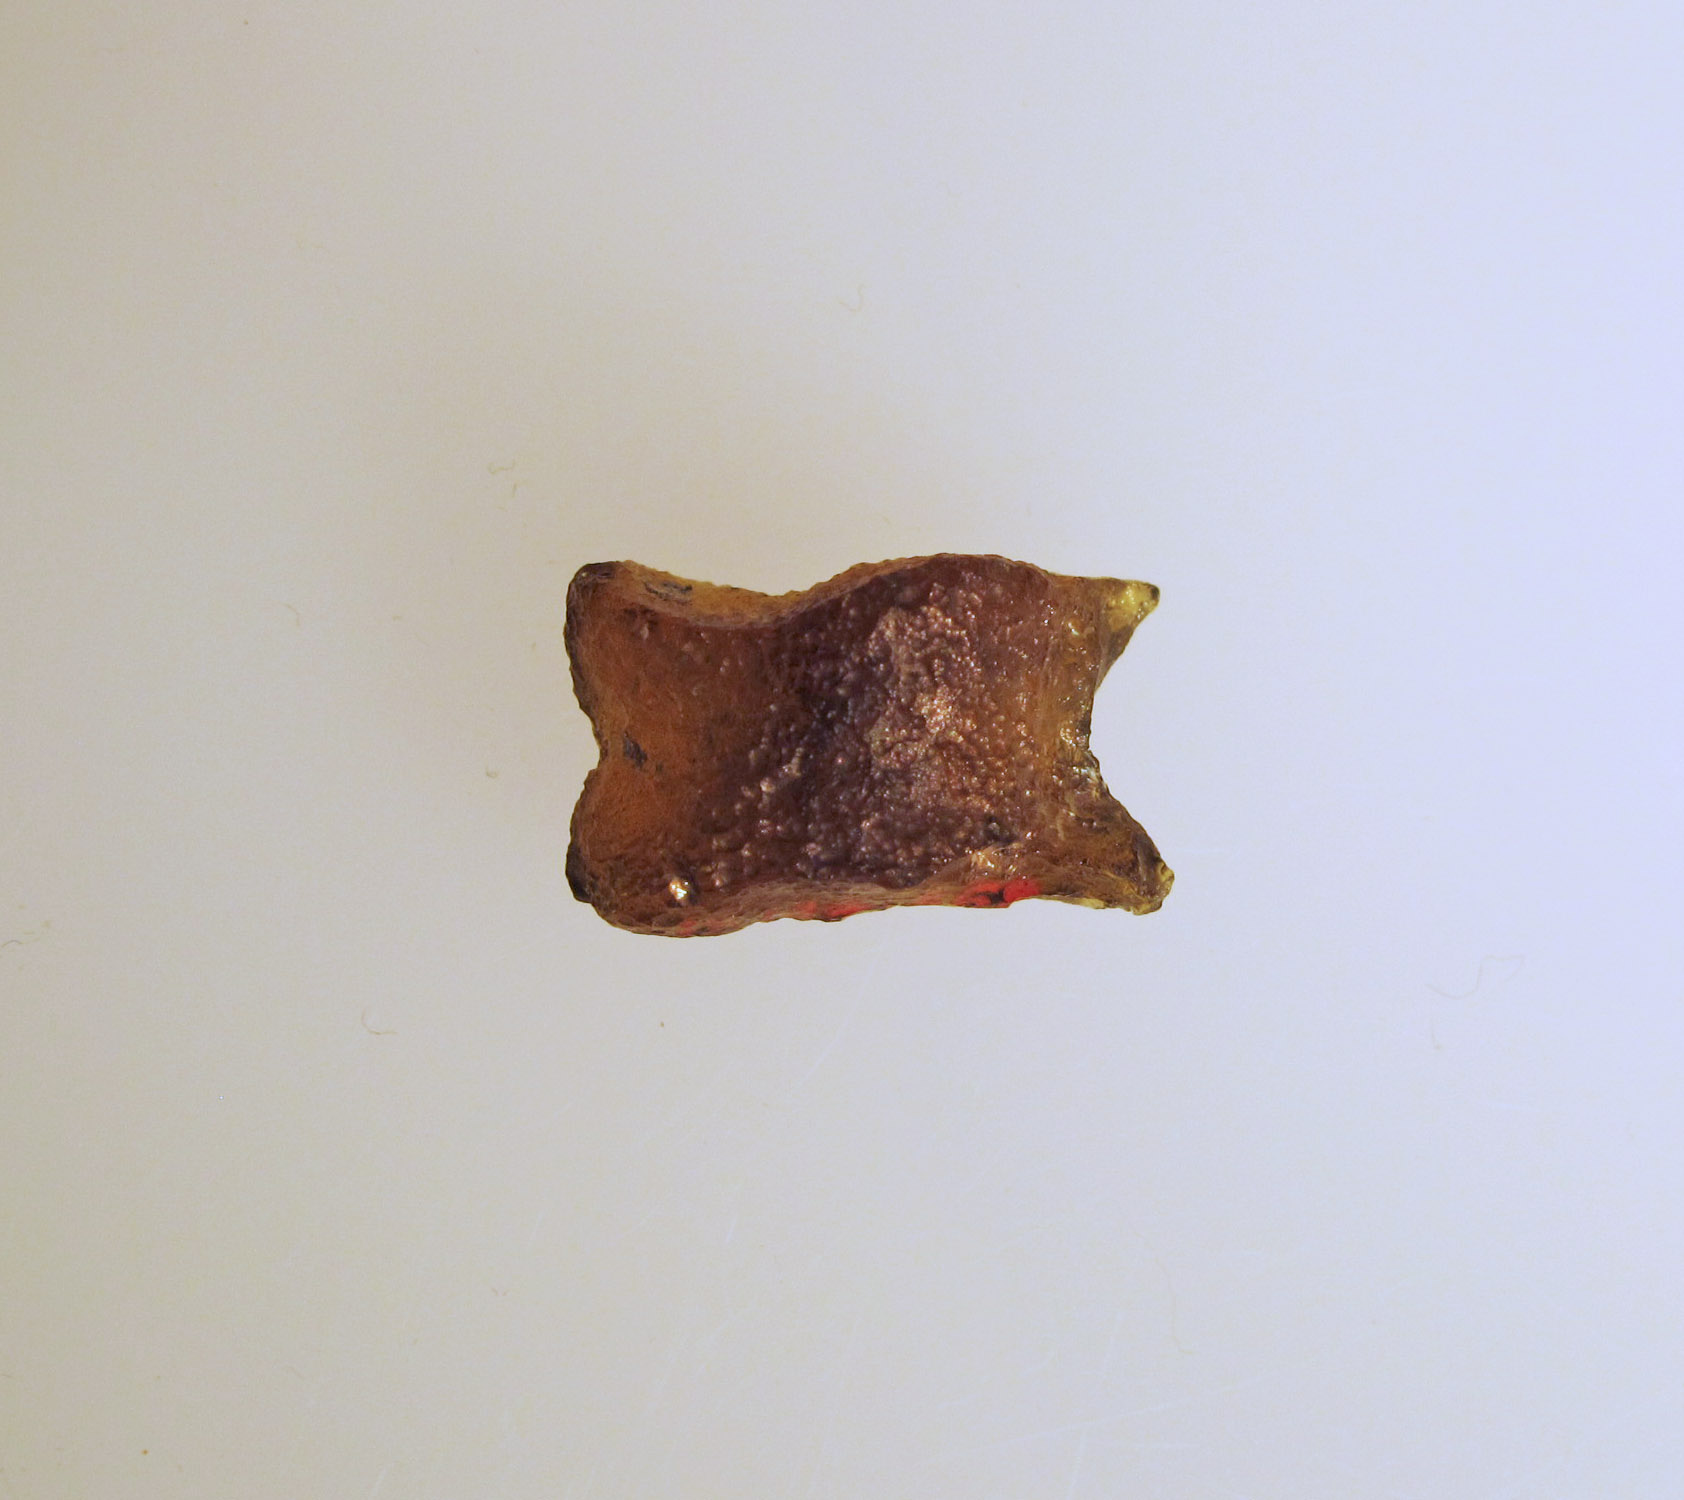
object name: astragal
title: Glass astragal (knucklebone)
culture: greek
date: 300-101 BCE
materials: glass